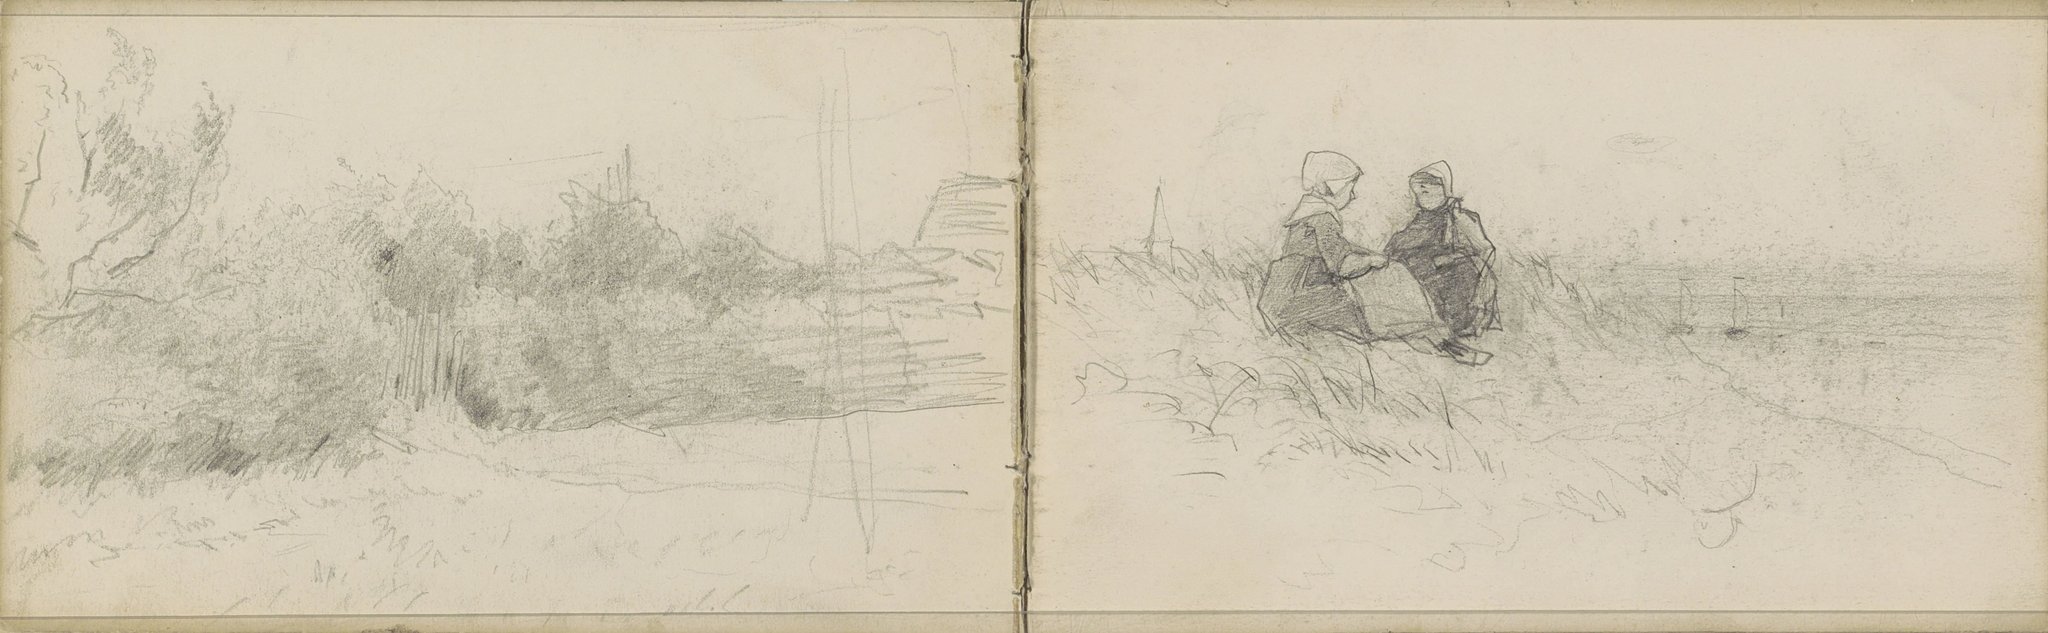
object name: sketchbook leaf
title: Twee meisjes zittend op een duin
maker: anton mauve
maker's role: draughtsman, painter, print maker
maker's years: 1838-1888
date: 1848-1888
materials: paper, pencil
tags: dune coast, girl (child between toddler and youth), folk costume, regional costume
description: De meisjes dragen klederdracht. Achter het duin zijn zeilschepen op zee te zien. Blad 36 verso en 37 recto uit een schetsboek met 42 bladen.